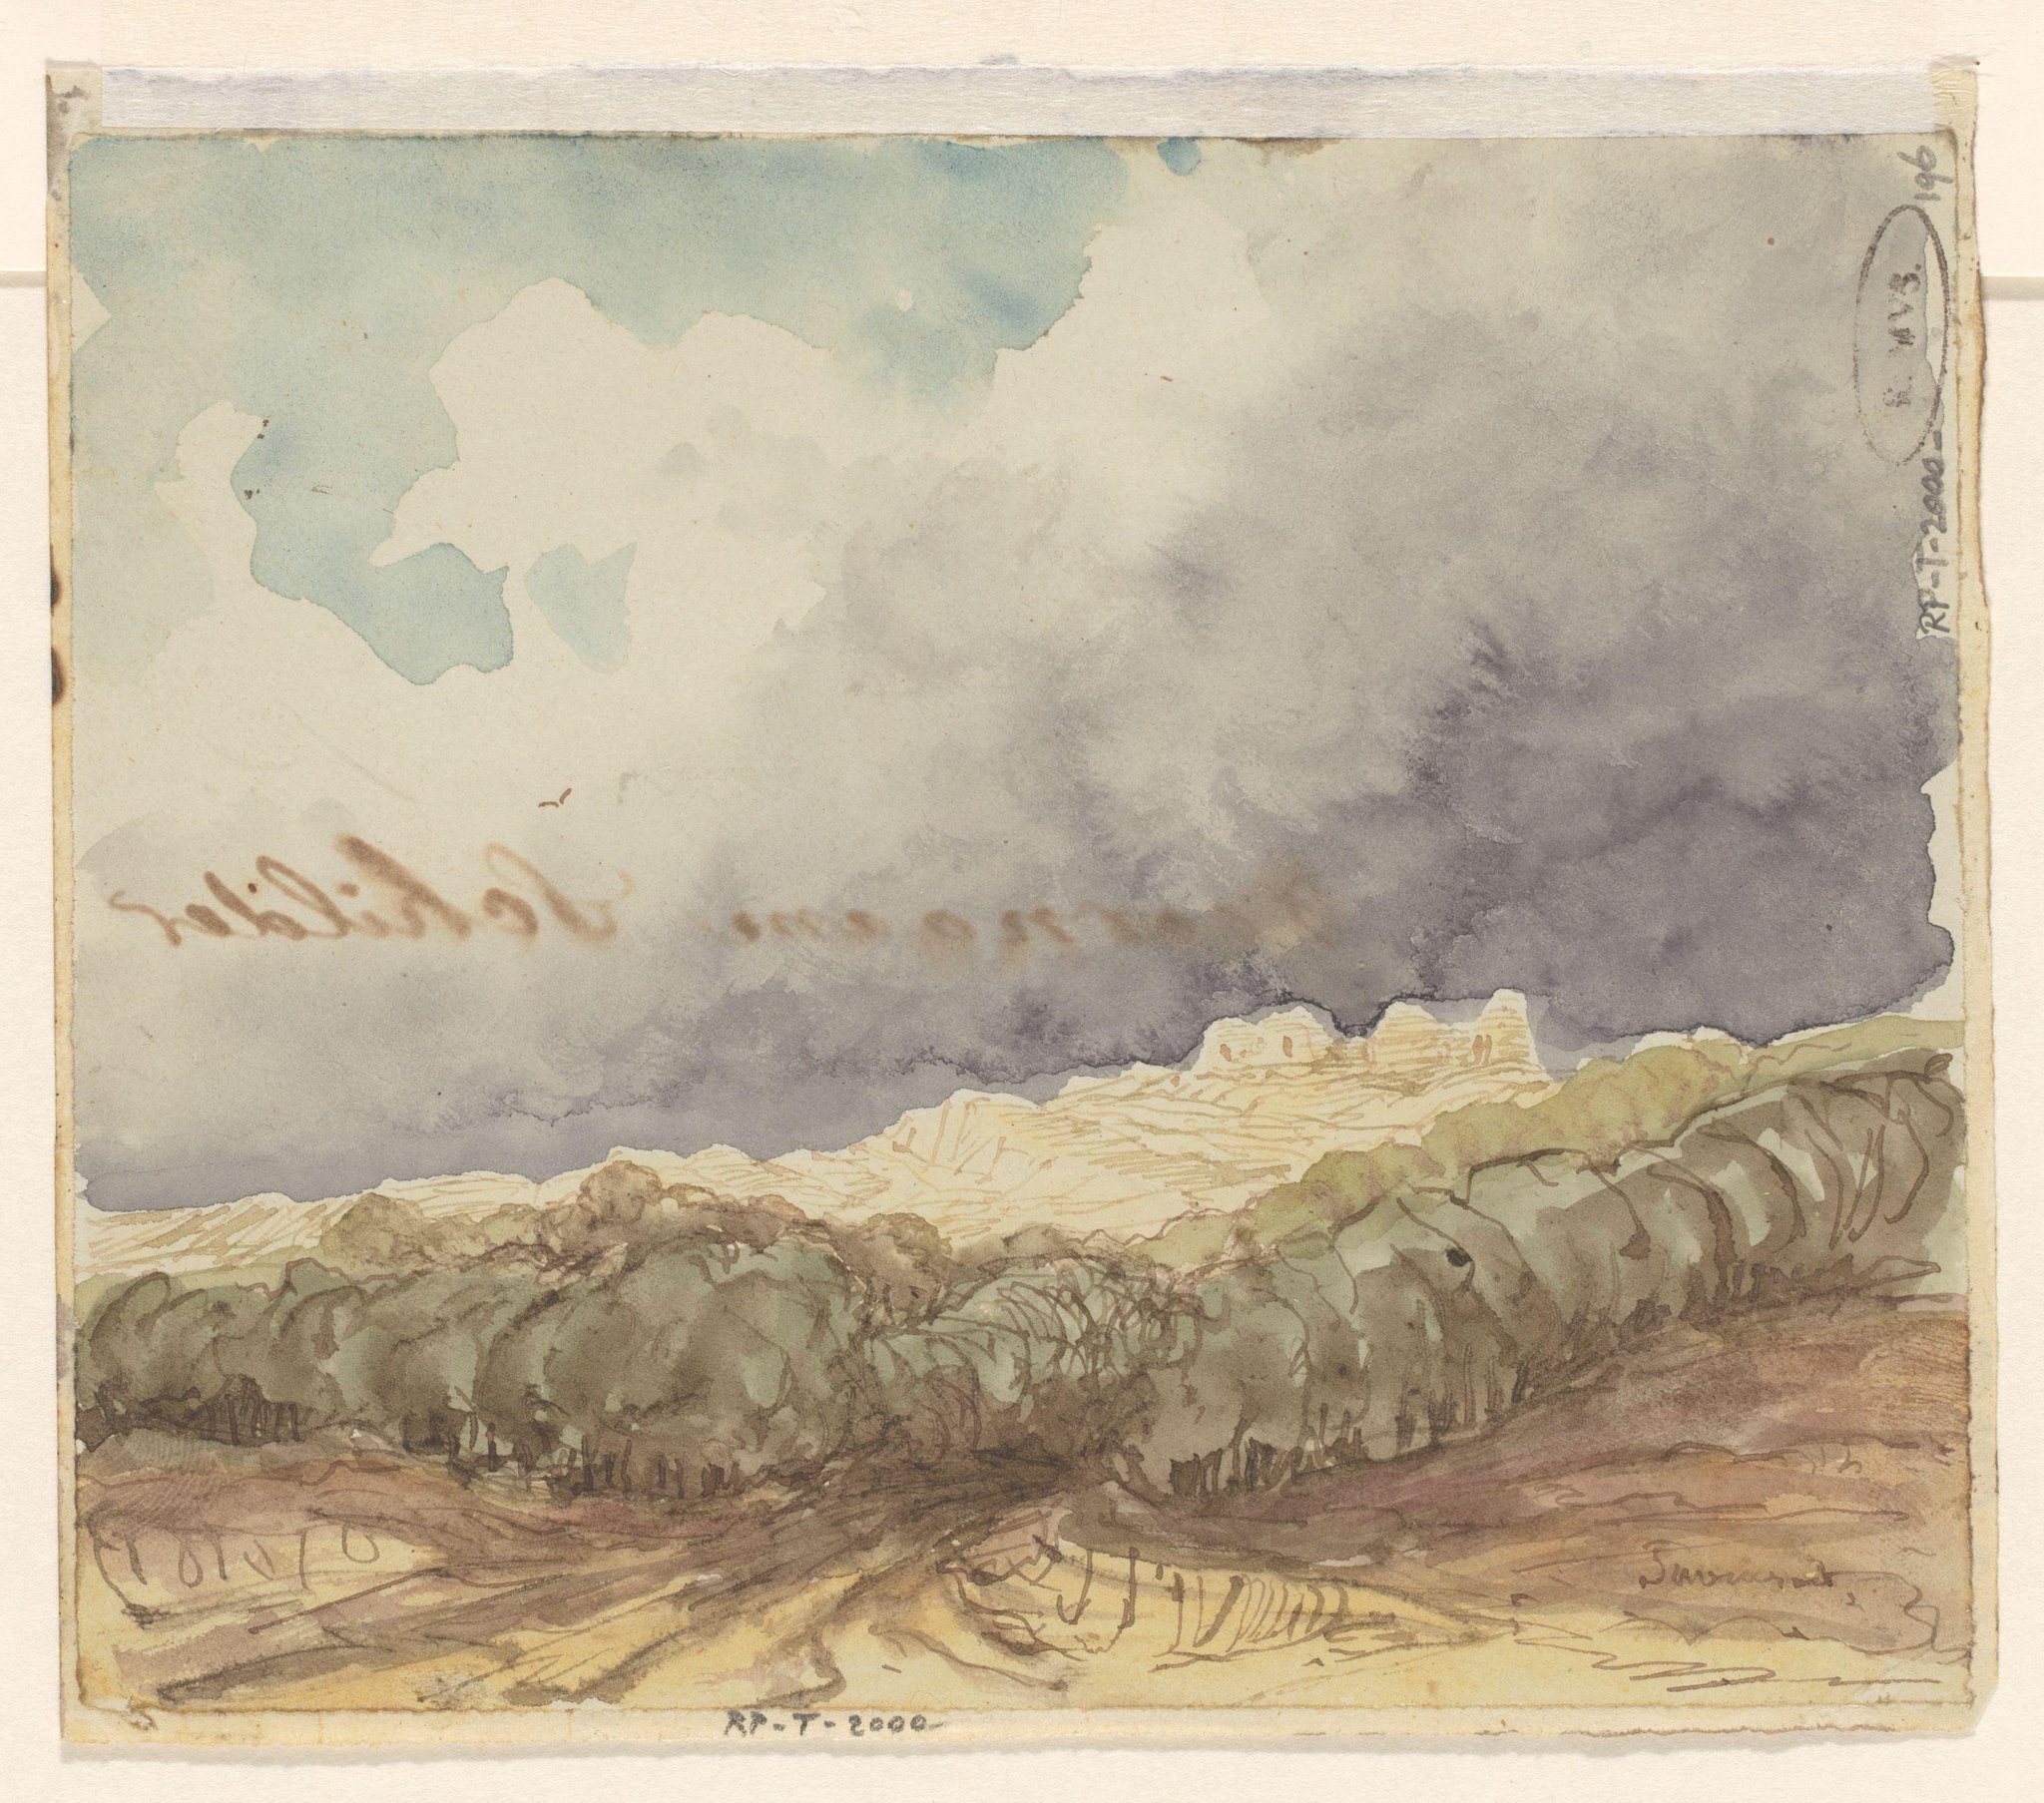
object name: drawing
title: Landschap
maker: johannes tavenraat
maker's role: draughtsman, painter, print maker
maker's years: 1809-1881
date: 1840-1880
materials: ink, paper, watercolor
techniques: brush, pen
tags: forest, wood, rocks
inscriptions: collector's mark: Lugt 2228, signature: ‘Tavenraat’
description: Landschap met bos, rotsen en wolkenlucht.